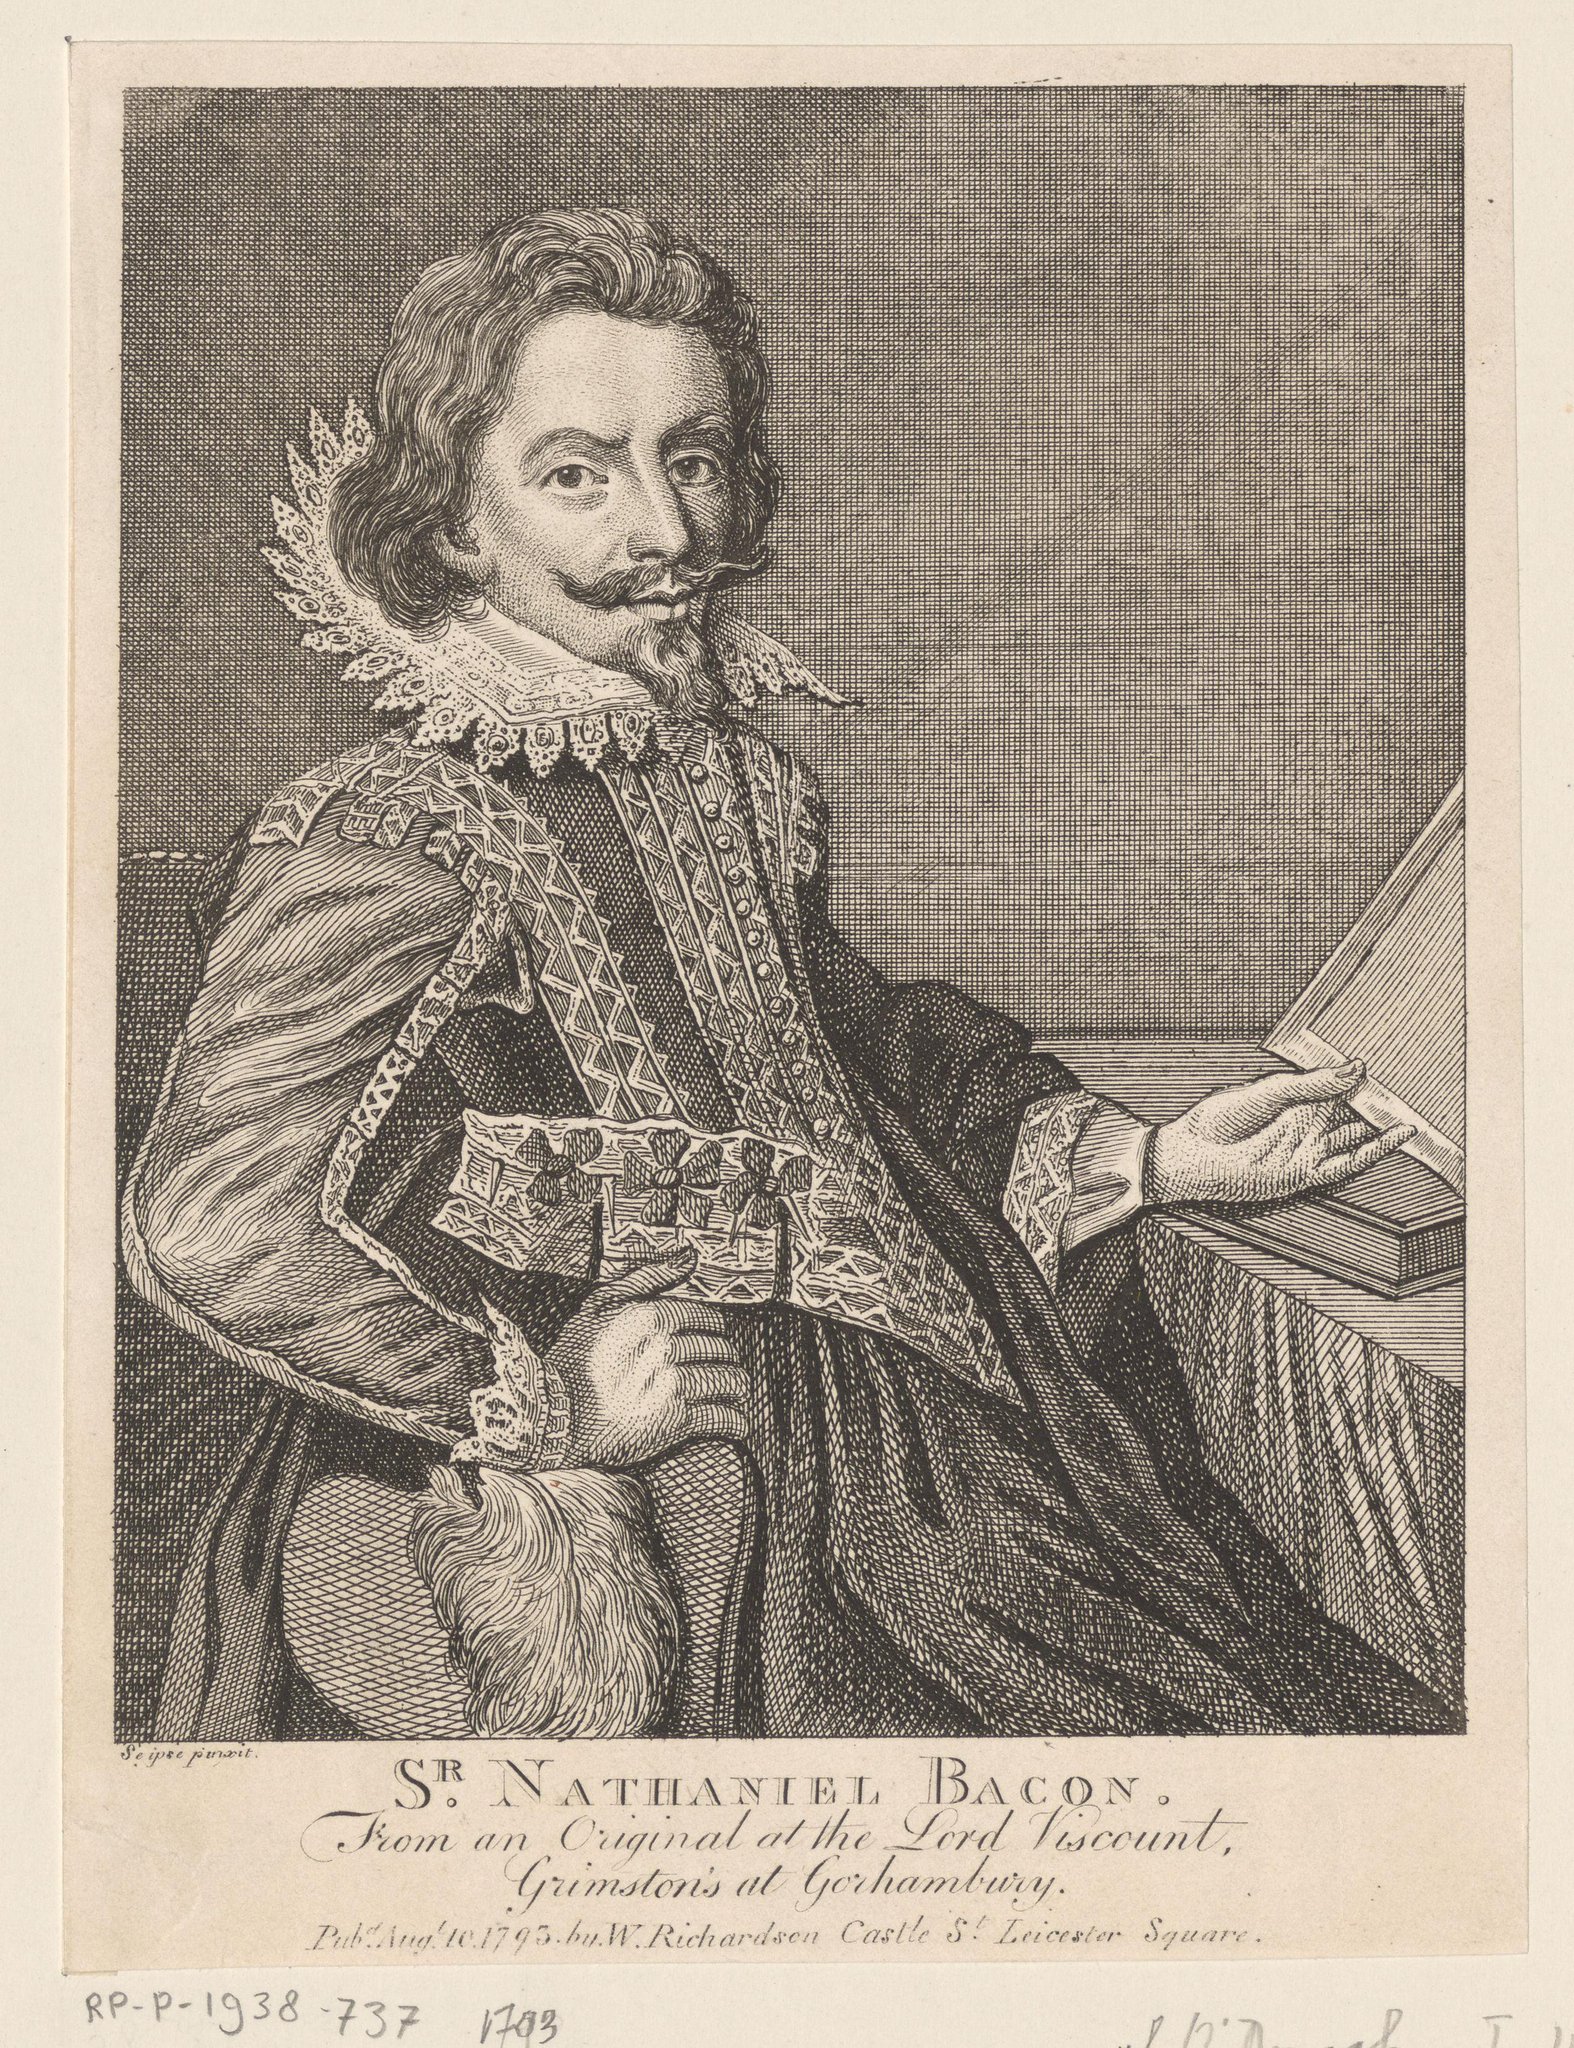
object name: print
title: Portret van Nathaniel Bacon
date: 1793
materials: paper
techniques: engraving, etching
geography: london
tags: nathaniel bacon (kolonist), historical persons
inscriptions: collector's mark: Lugt 2228